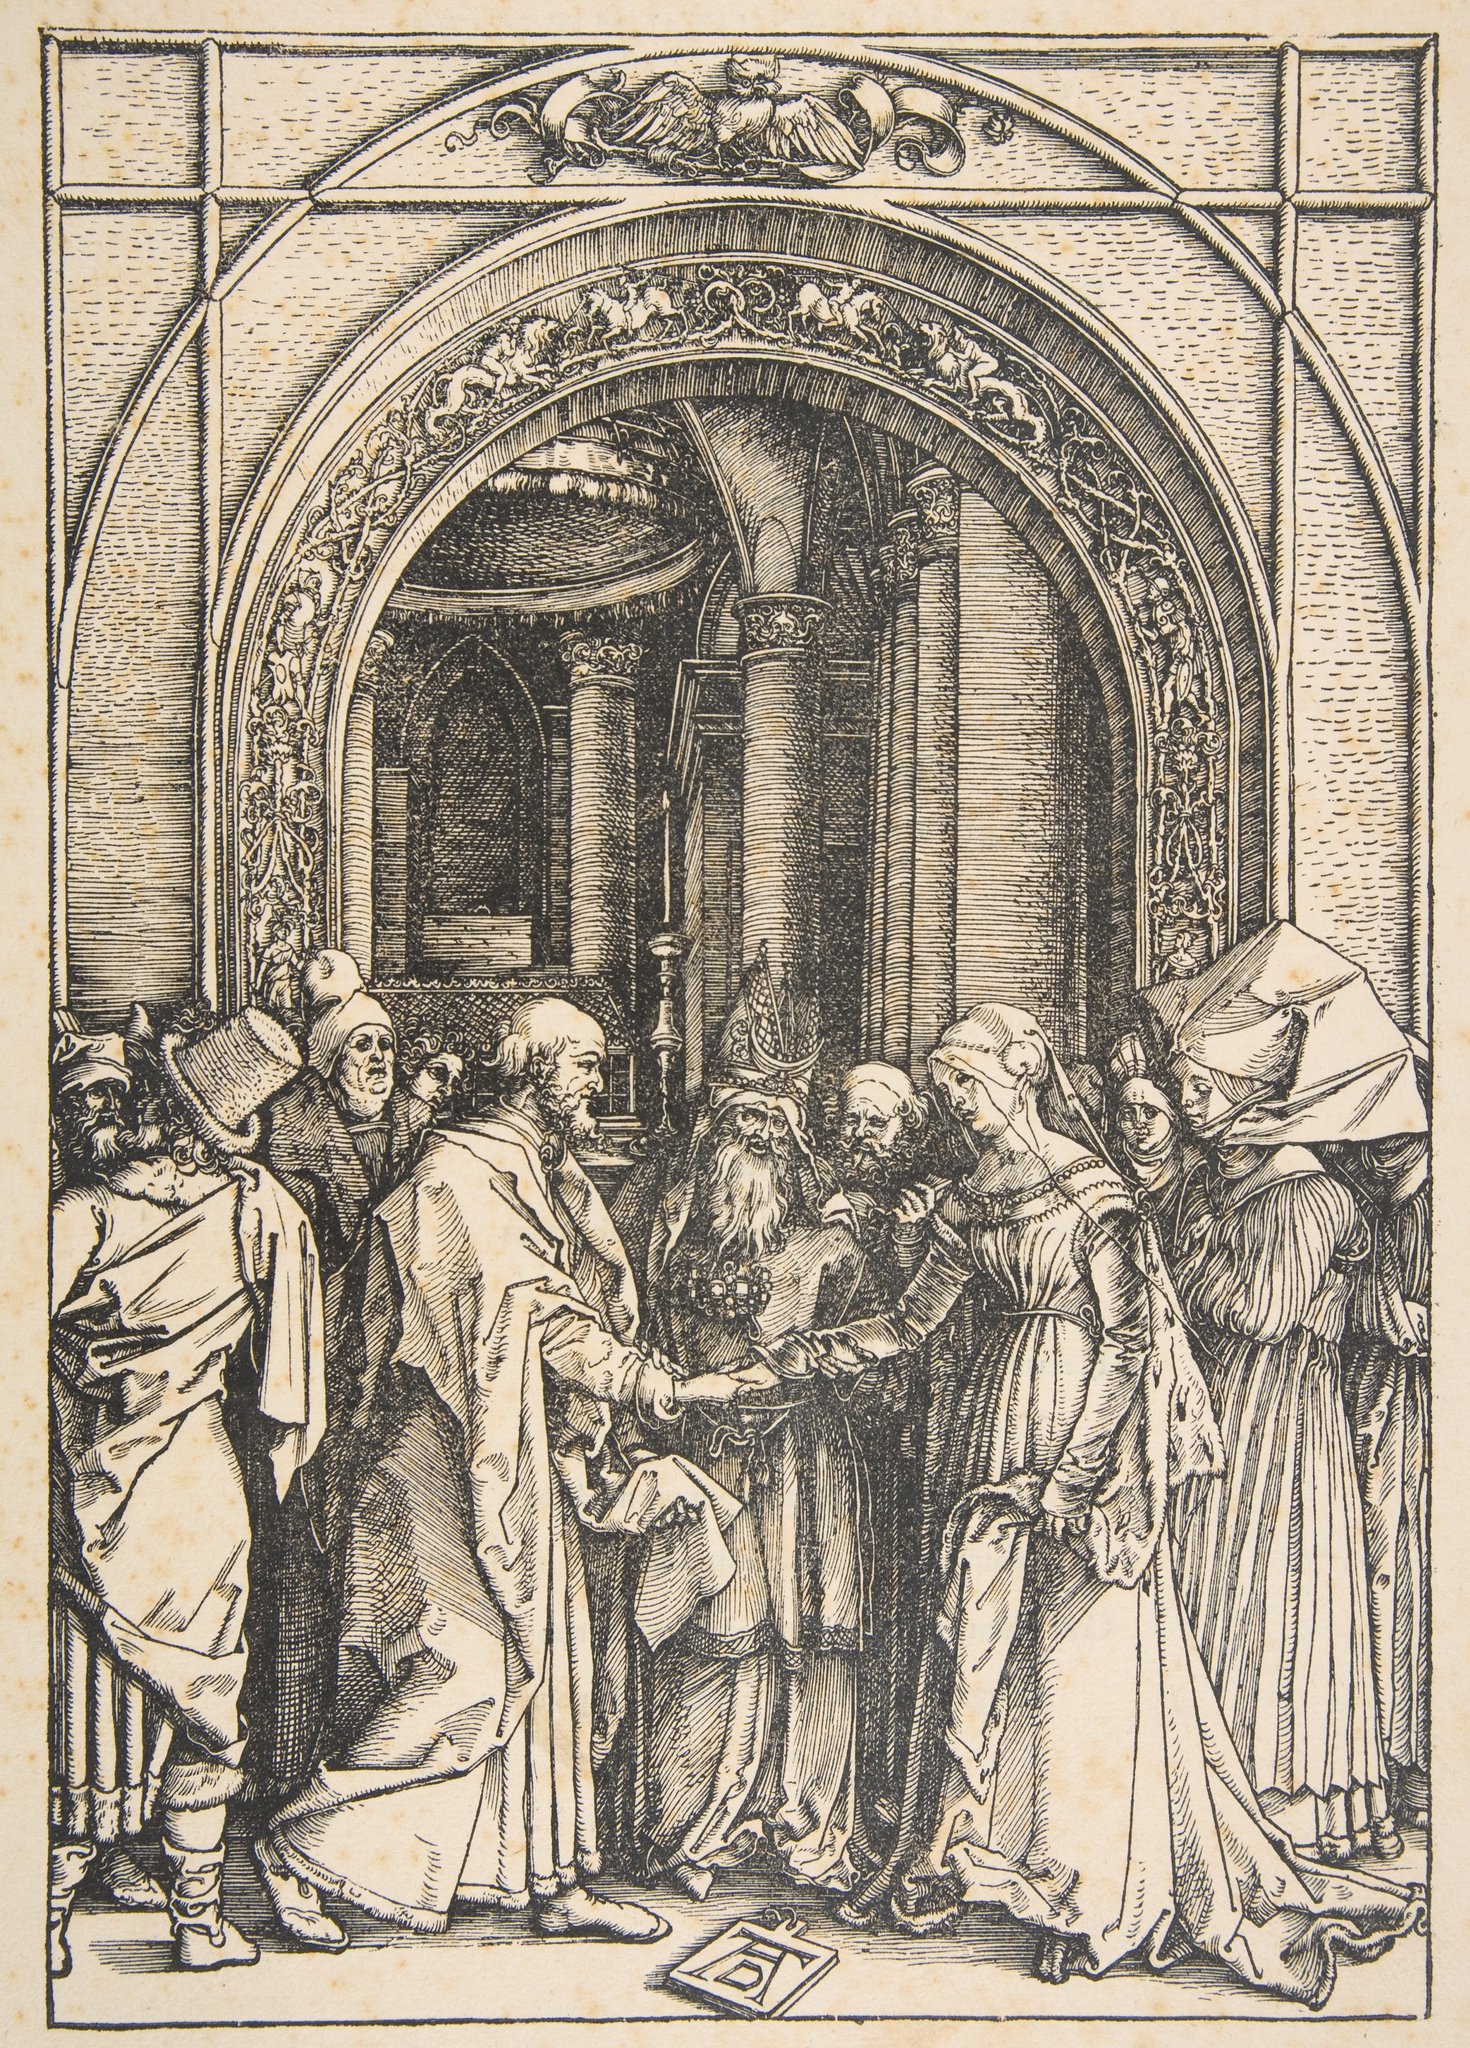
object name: print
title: The Betrothal of the Virgin, from "The Life of the Virgin"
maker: albrecht dürer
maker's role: artist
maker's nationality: german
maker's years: 1471-1528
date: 1504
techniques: woodcut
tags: men,women,virgin mary,joseph,marriage of the virgin